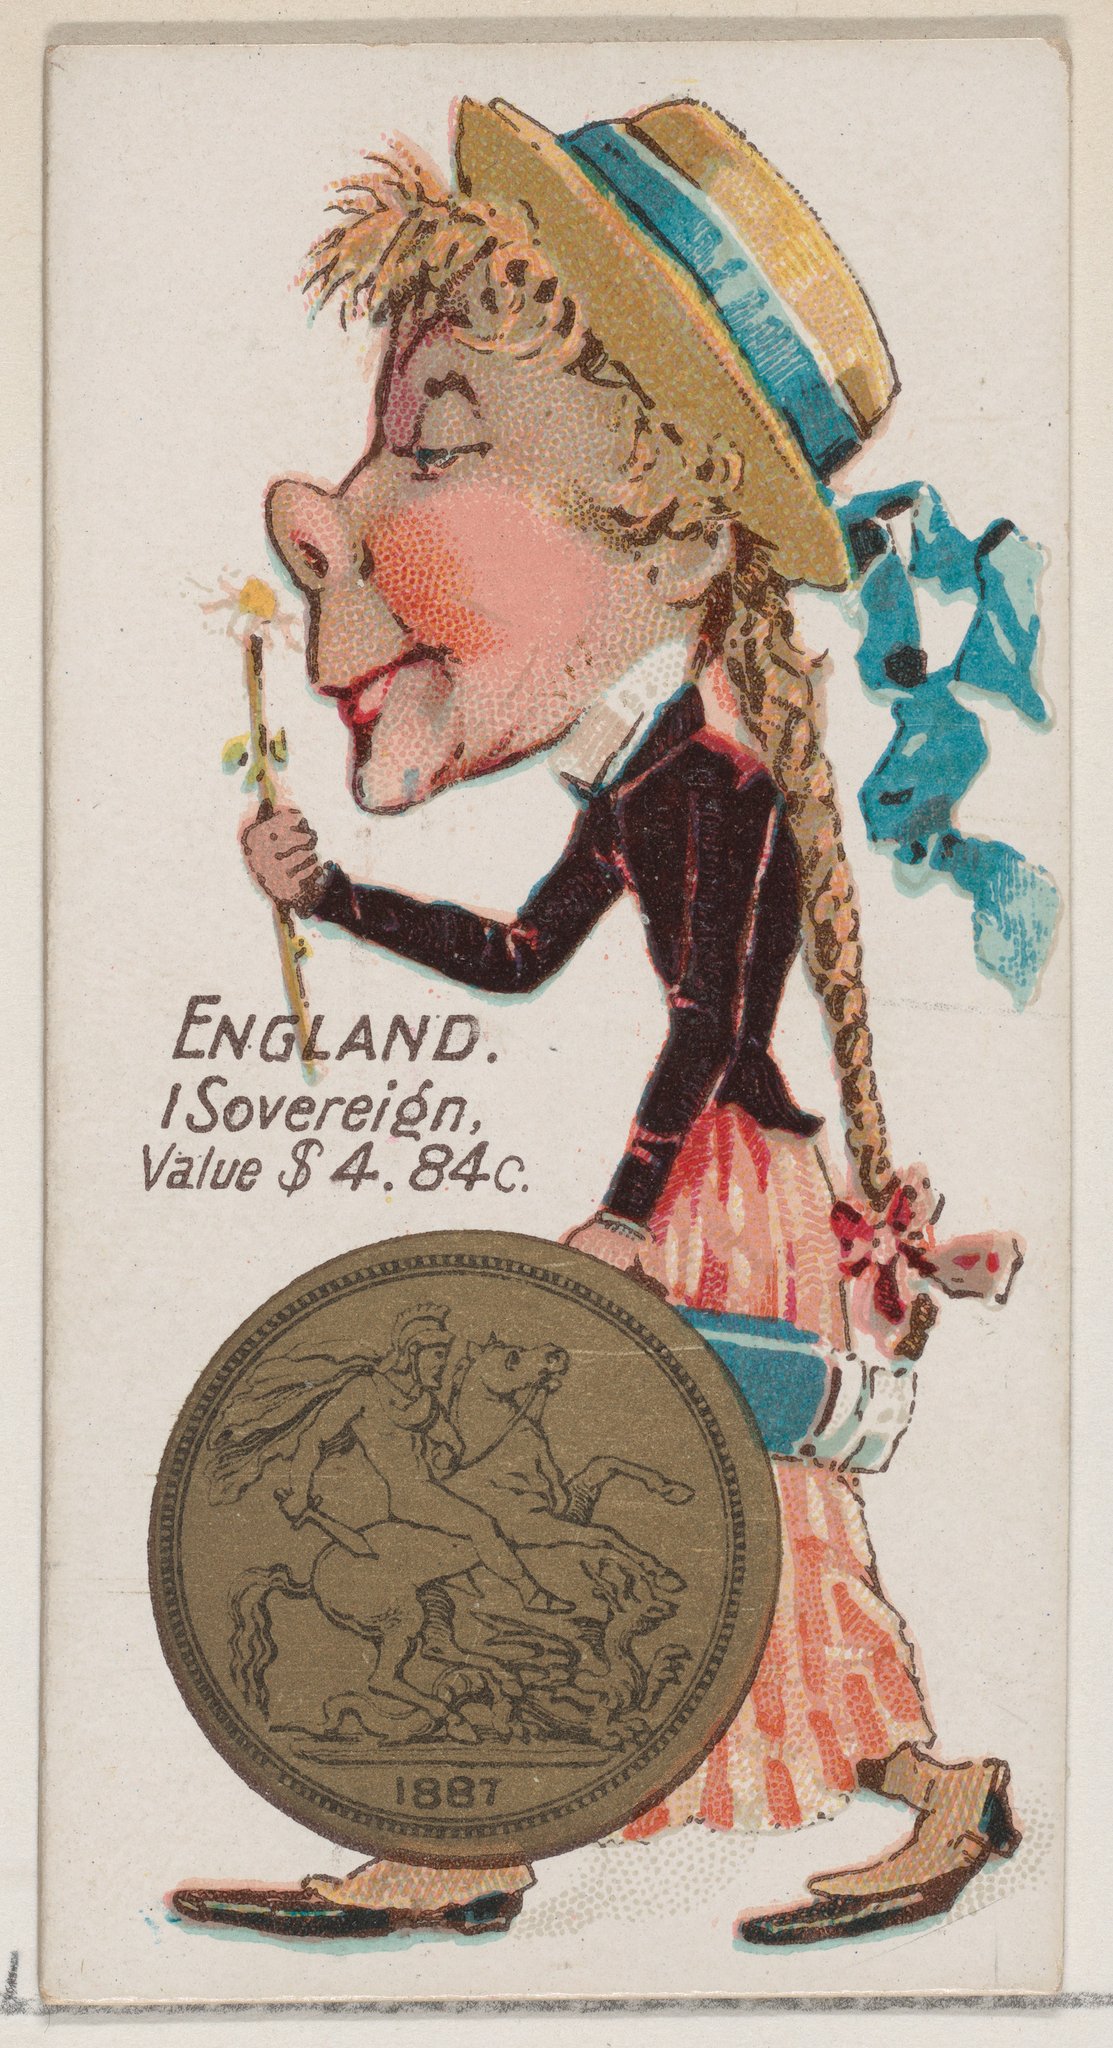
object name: print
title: England, 1 Sovereign, from the series Coins of All Nations (N72, variation 1) for Duke brand cigarettes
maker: w. duke, sons & co.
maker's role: publisher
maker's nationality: american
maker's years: 1870-1920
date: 1889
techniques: color lithograph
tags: women,coins